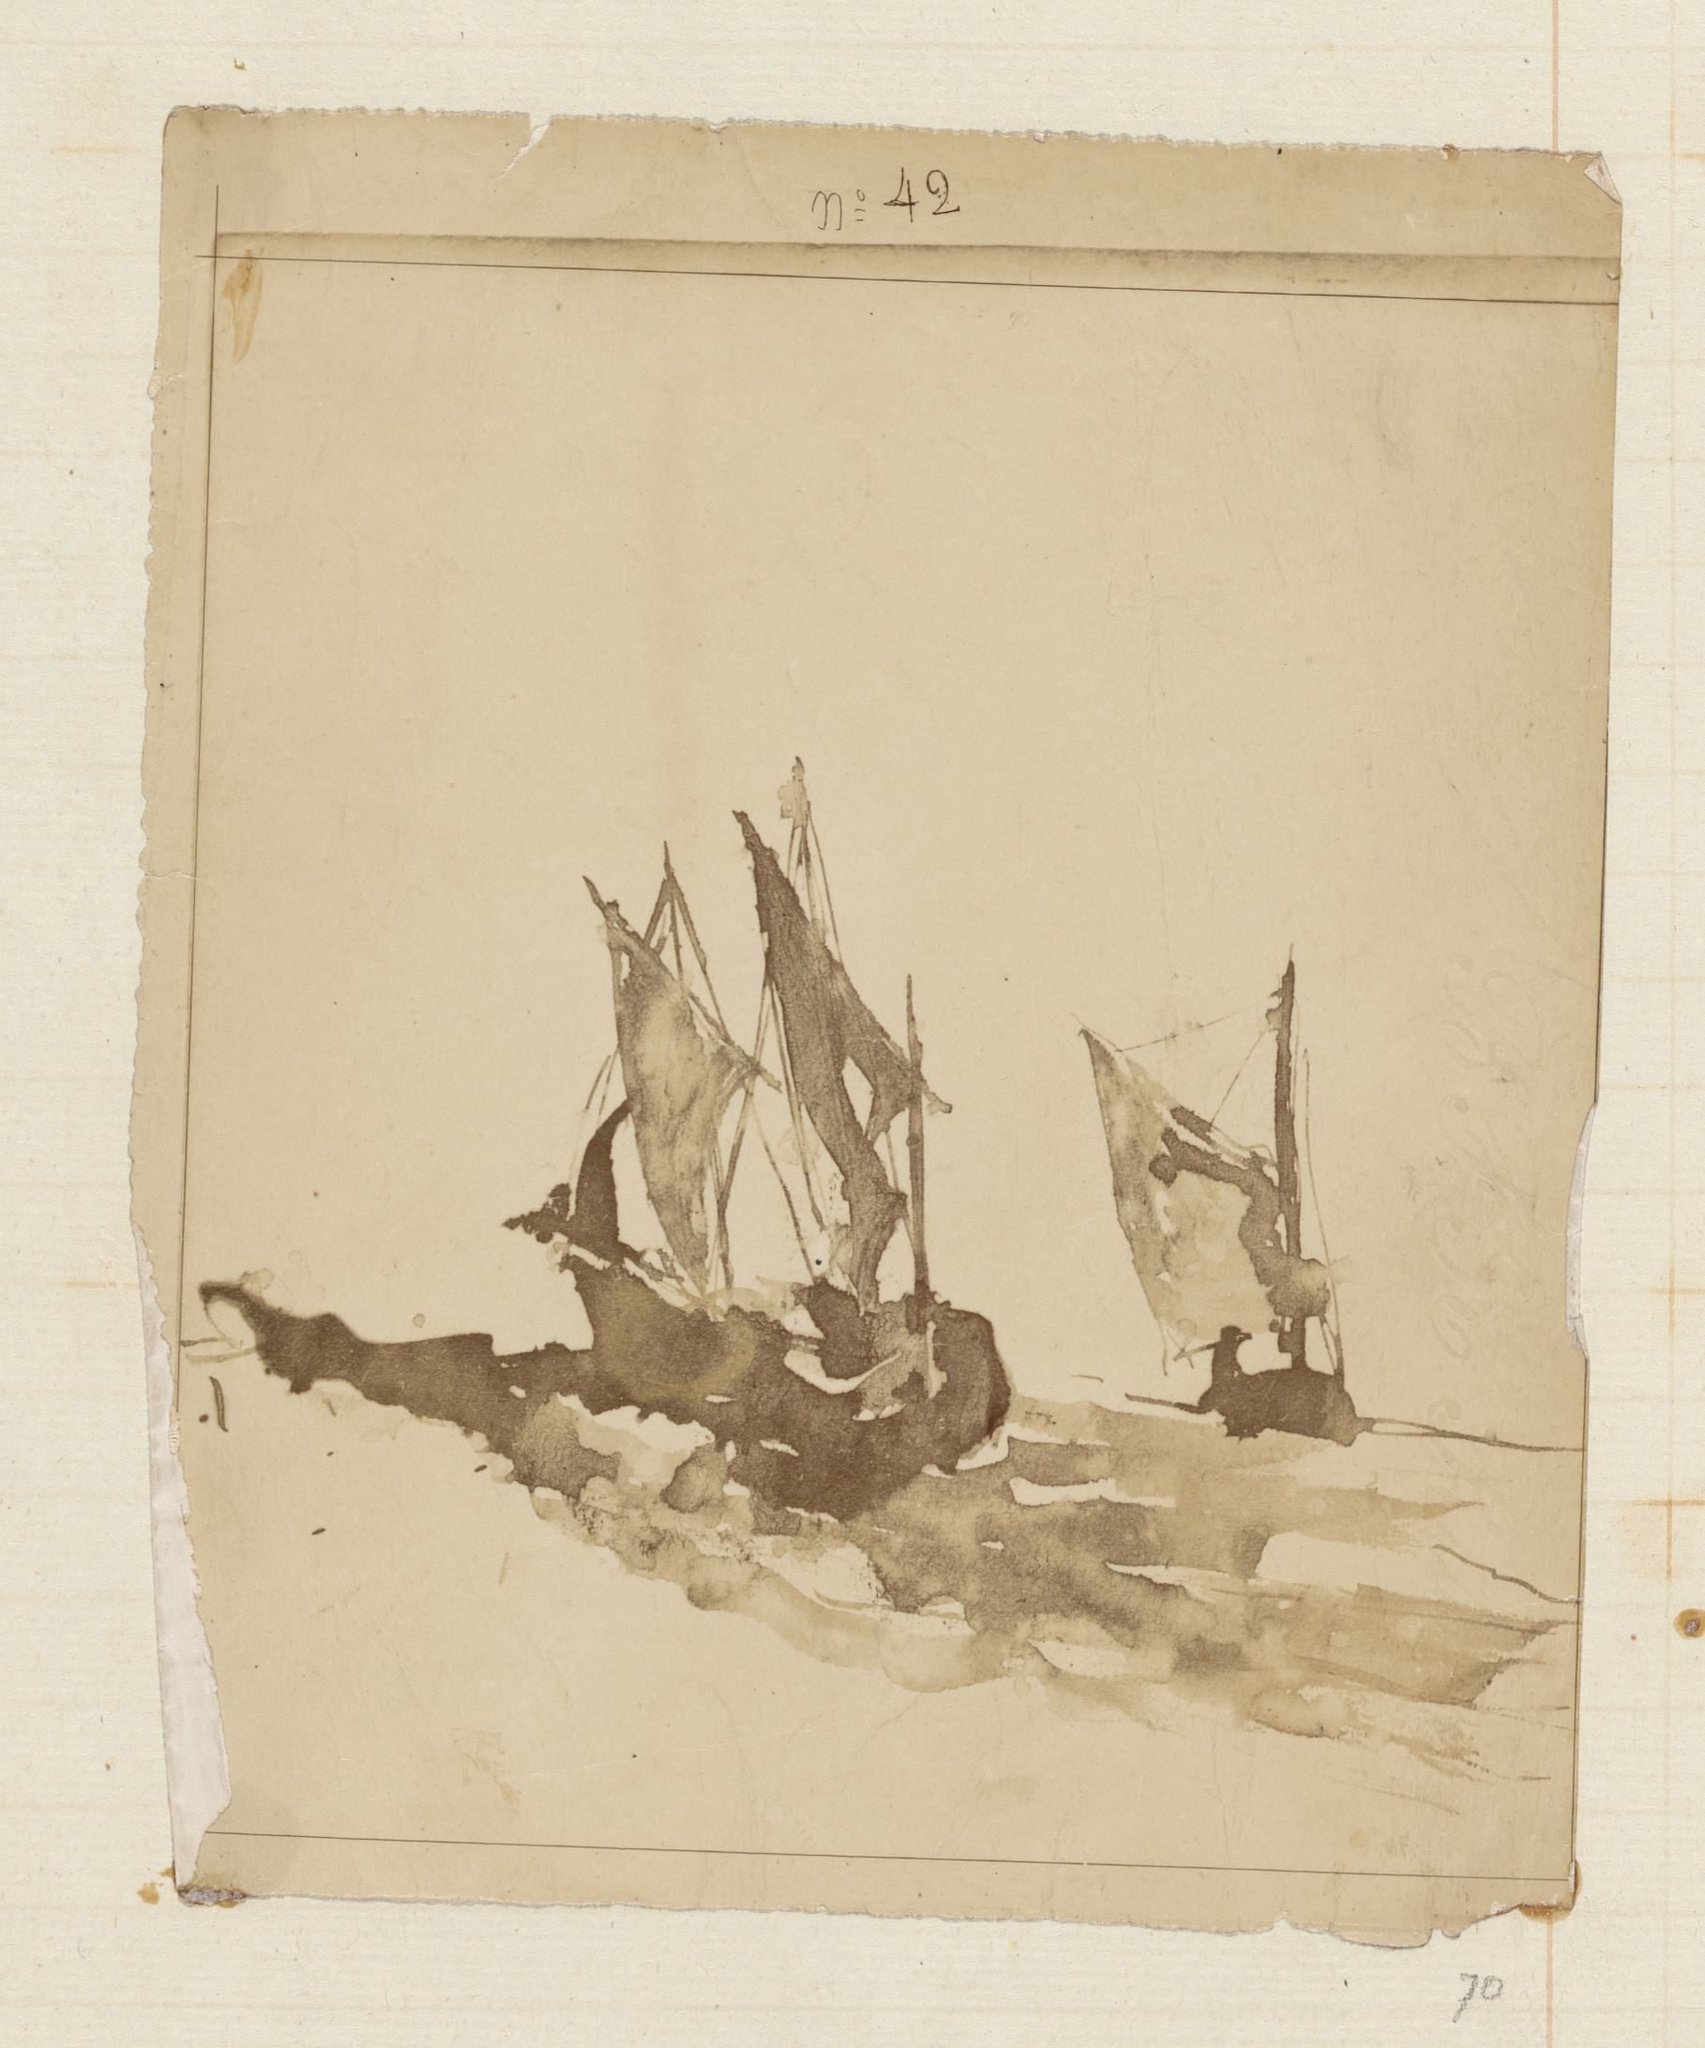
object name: photograph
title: Fotoreproductie van (vermoedelijk) een aquarel, voorstellend zeilschepen op zee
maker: Anonymous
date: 1880-1900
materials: paper, photographic support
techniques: albumen print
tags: sailing-ship, sailing-boat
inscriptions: inscription: ‘B.F.K. Rives’